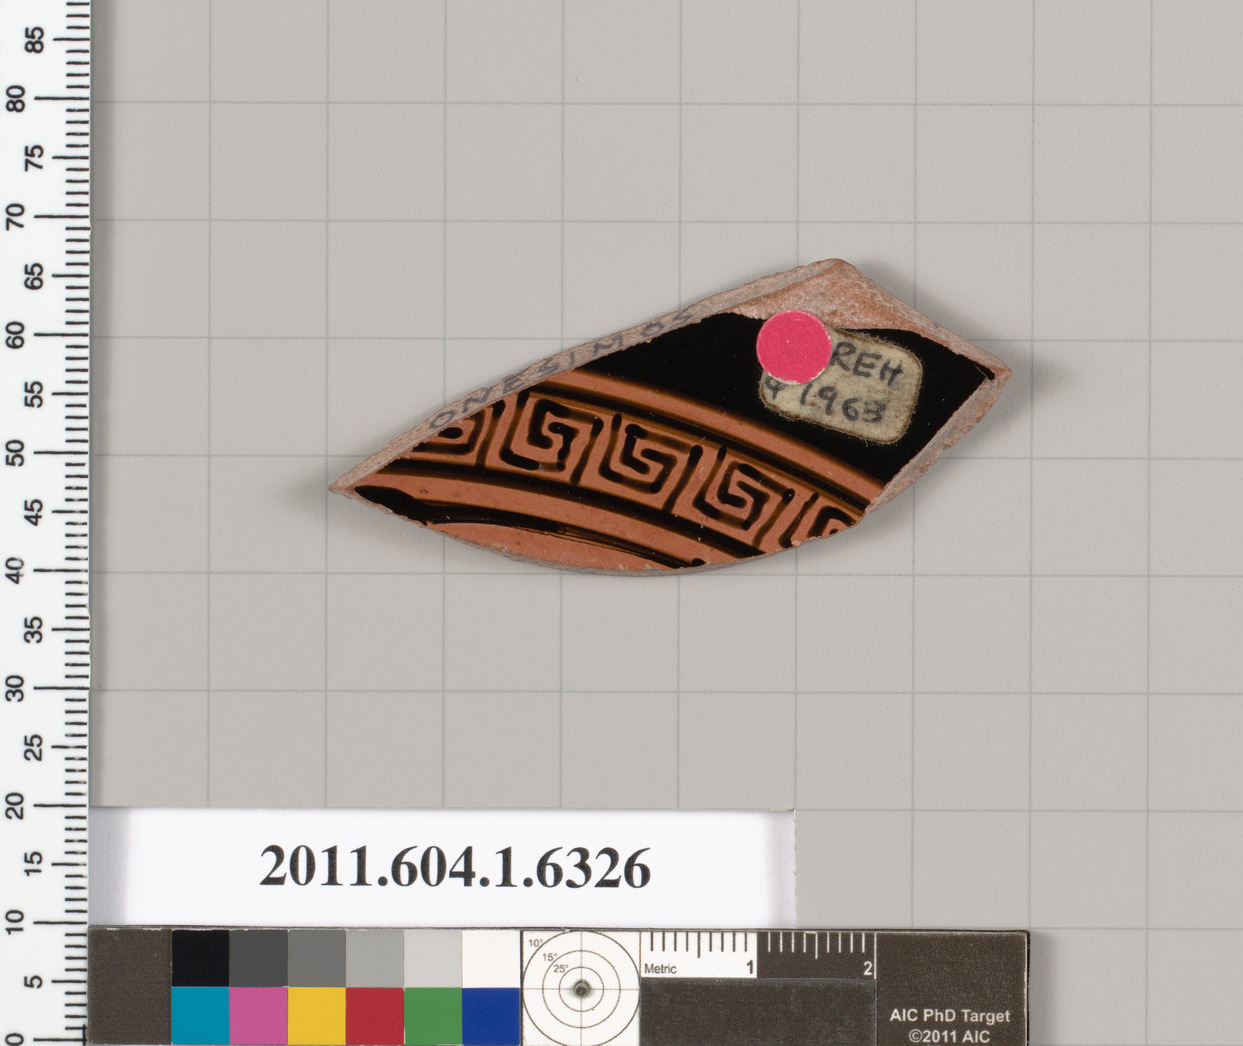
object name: kylix fragment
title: Terracotta fragment of a kylix (drinking cup)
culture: greek, attic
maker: onesimos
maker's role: artist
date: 500-480 BCE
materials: terracotta